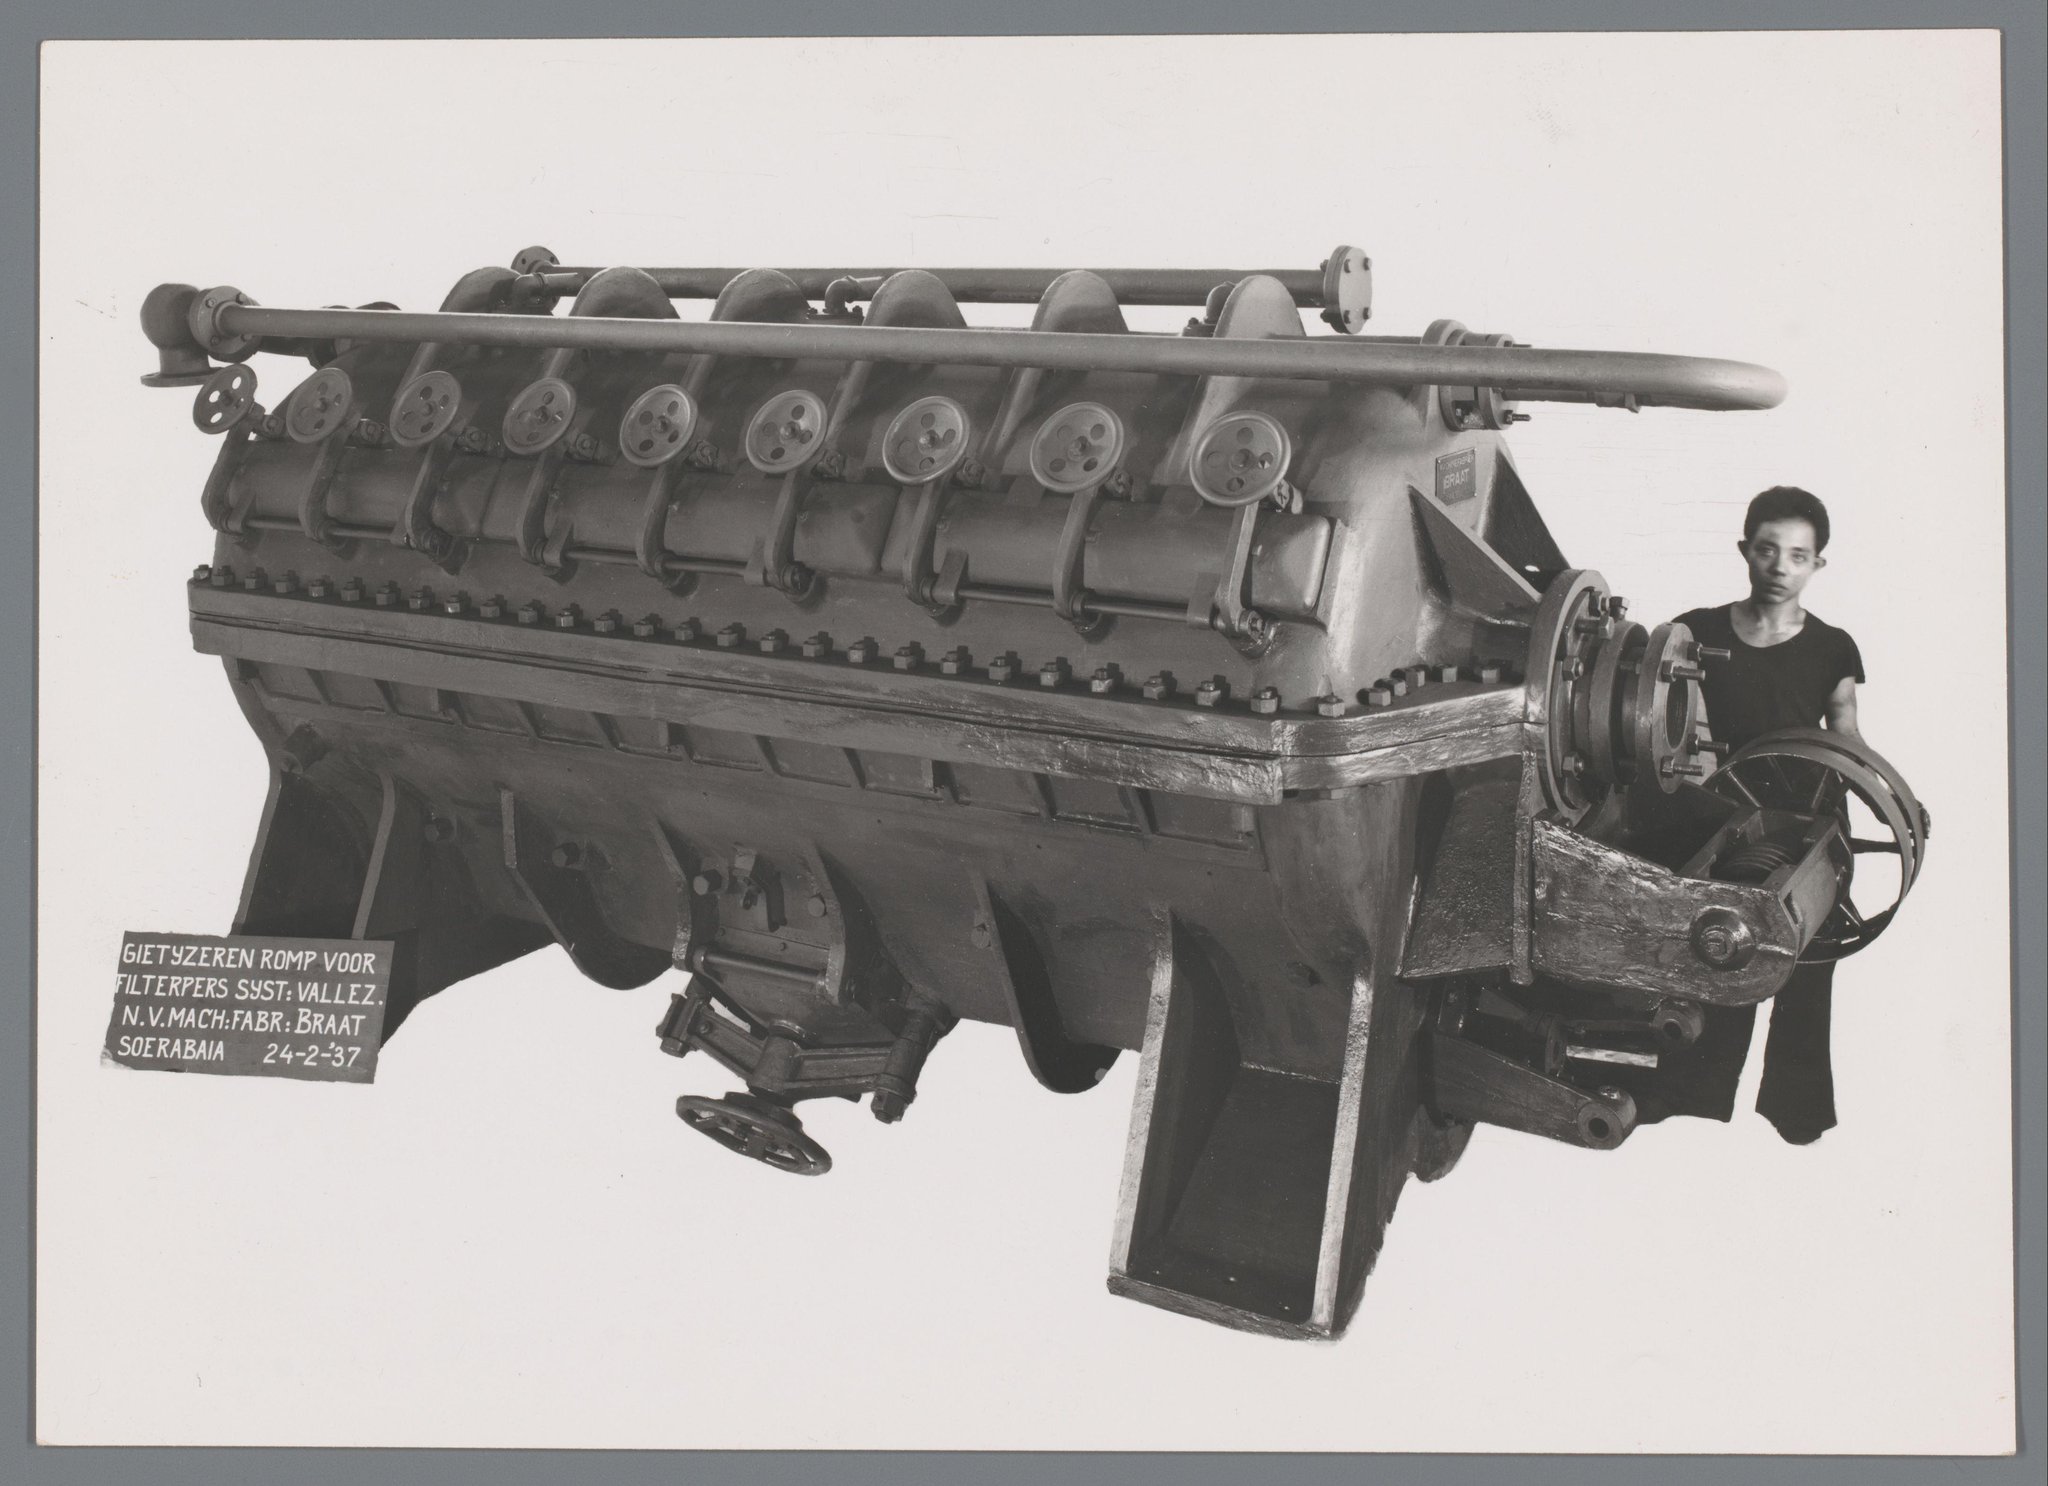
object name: photograph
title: Romp voor filterpers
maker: Anonymous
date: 1937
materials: photographic support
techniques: gelatin silver print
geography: surabaya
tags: colonial system, machines; parts of machines; tools and appliances, factory-interior, machine shop (+ men (labourers)), java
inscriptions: date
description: Een gietijzeren romp voor een filterpers, vervaardigd in 1937 en bestemd voor de Suikerfabriek Manishardjo ten noordoosten van Klaten op Java. Onderdeel van de multomap met foto's van machines van de N.V. Machinefabriek Braat te Soerabaja, Soekaboemi en Jogyakarta, uit de periode 1908-1942.